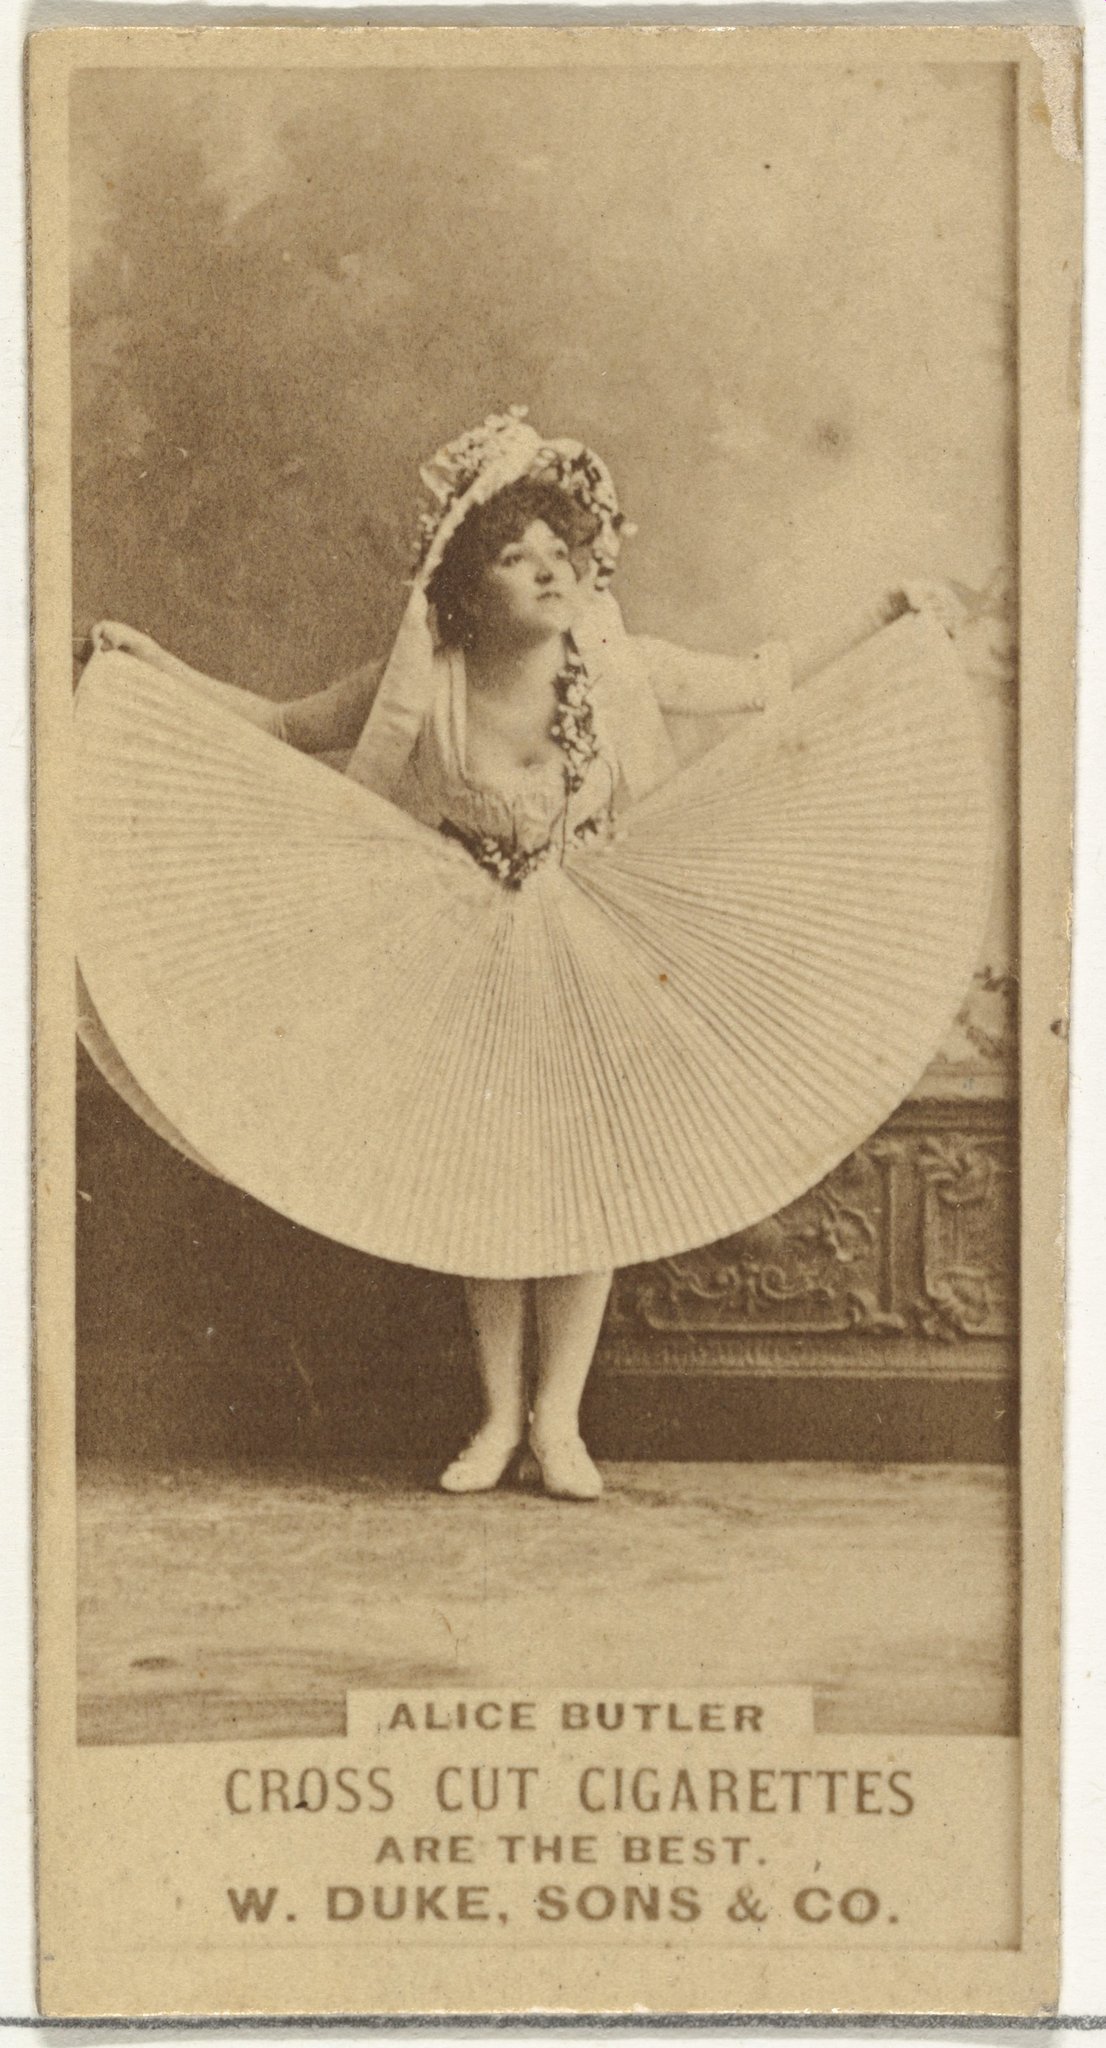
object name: photograph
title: Alice Butler, from the Actors and Actresses series (N145-3) issued by Duke Sons & Co. to promote Cross Cut Cigarettes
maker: w. duke, sons & co.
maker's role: publisher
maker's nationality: american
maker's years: 1870-1920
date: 1880-1889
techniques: albumen silver print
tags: portraits,women,actresses